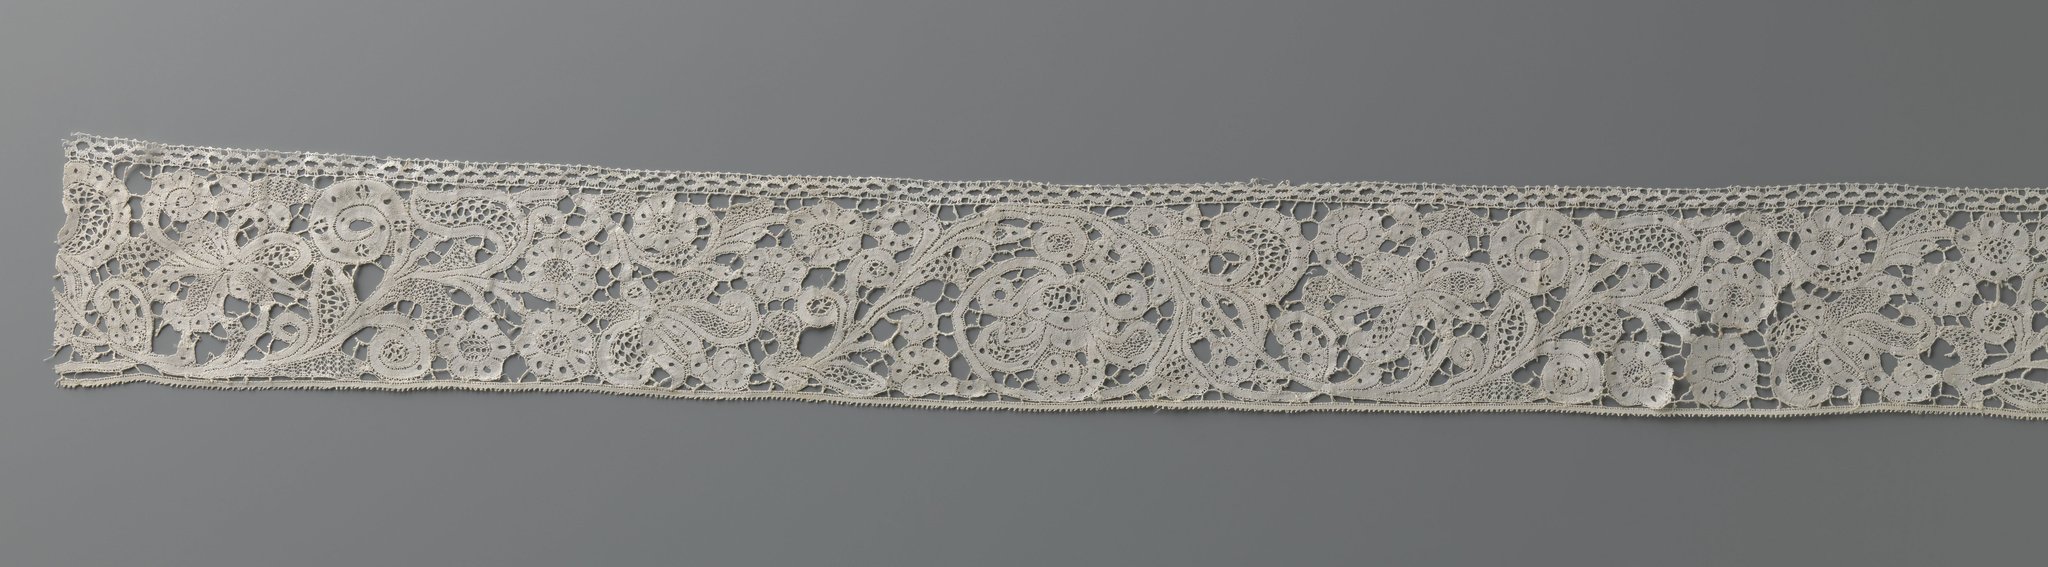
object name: strip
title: Strook gemengde kant met golvende stengel en verschillende grote bloemen en bladeren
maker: Anonymous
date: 1675-1699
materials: linen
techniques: lace, milan lace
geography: southern netherlands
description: Strook naturelkleurige gemengde kant: oude Milanese kant of oudvlaamse kloskant in delen, waarbij de gekloste motieven zijn verbonden door een naaldkantgrond van gefestoneerde spijlen met picots. Het zich herhalende patroon bestaat uit een golvende stengel met één golftop en één golfdal en verschillende grote bloemen en bladeren aan omkrullende zijtakken. Tussen de opeenvolgende golvende stengels hangt een exotische bloem die is omringd door verschillende rozetbloemen. De omtrekken van de motieven zijn grotendeels gemaakt in linnenslag met opengewerkte randjes en forse uitsparingen. Binnen de contouren van de bloemen en bladeren is een grote verscheidenheid aan siergronden toegepast. Boven en onderzijde van de strook zijn met rechte bandjes afgewerkt. Het bovenste bandje is geklost met een keten van opengewerkte ovaaltjes. Het onderste bandje is recht en smal en gemaakt in linnenslag met picots.